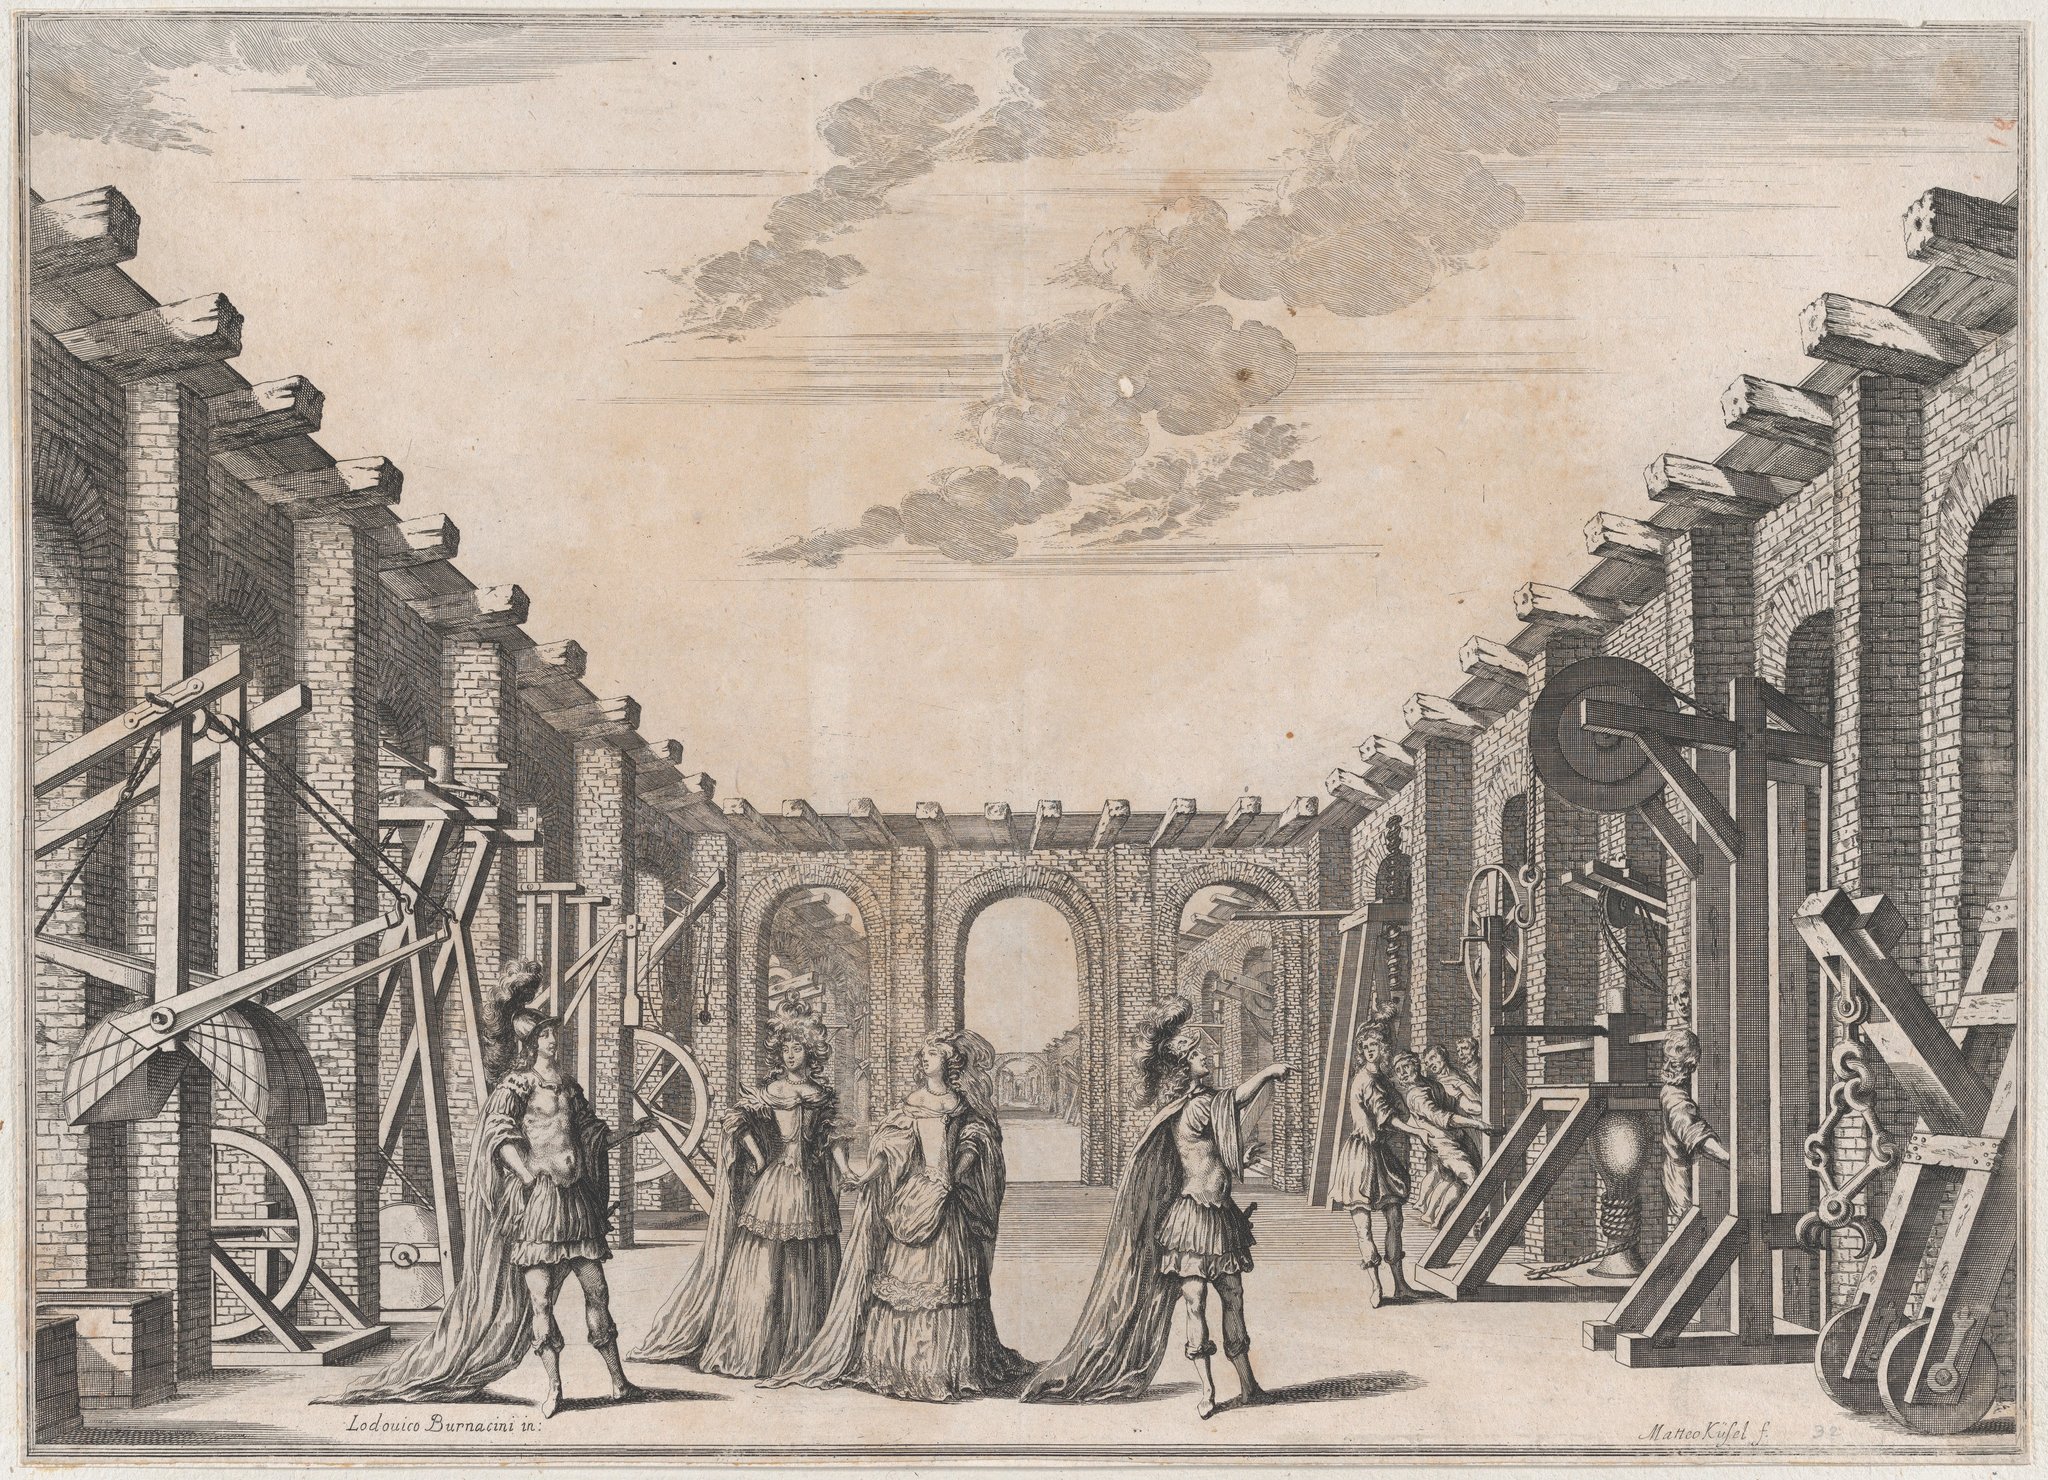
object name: print, fete, ornament architecture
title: Two men in classical armor and two women looking at the mechanical devices on either side of an open courtyard; set design from 'Il Fuoco Eterno'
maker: mathäus küsel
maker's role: artist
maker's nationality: german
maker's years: 1621-1682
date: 1674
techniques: etching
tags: men,women,machines